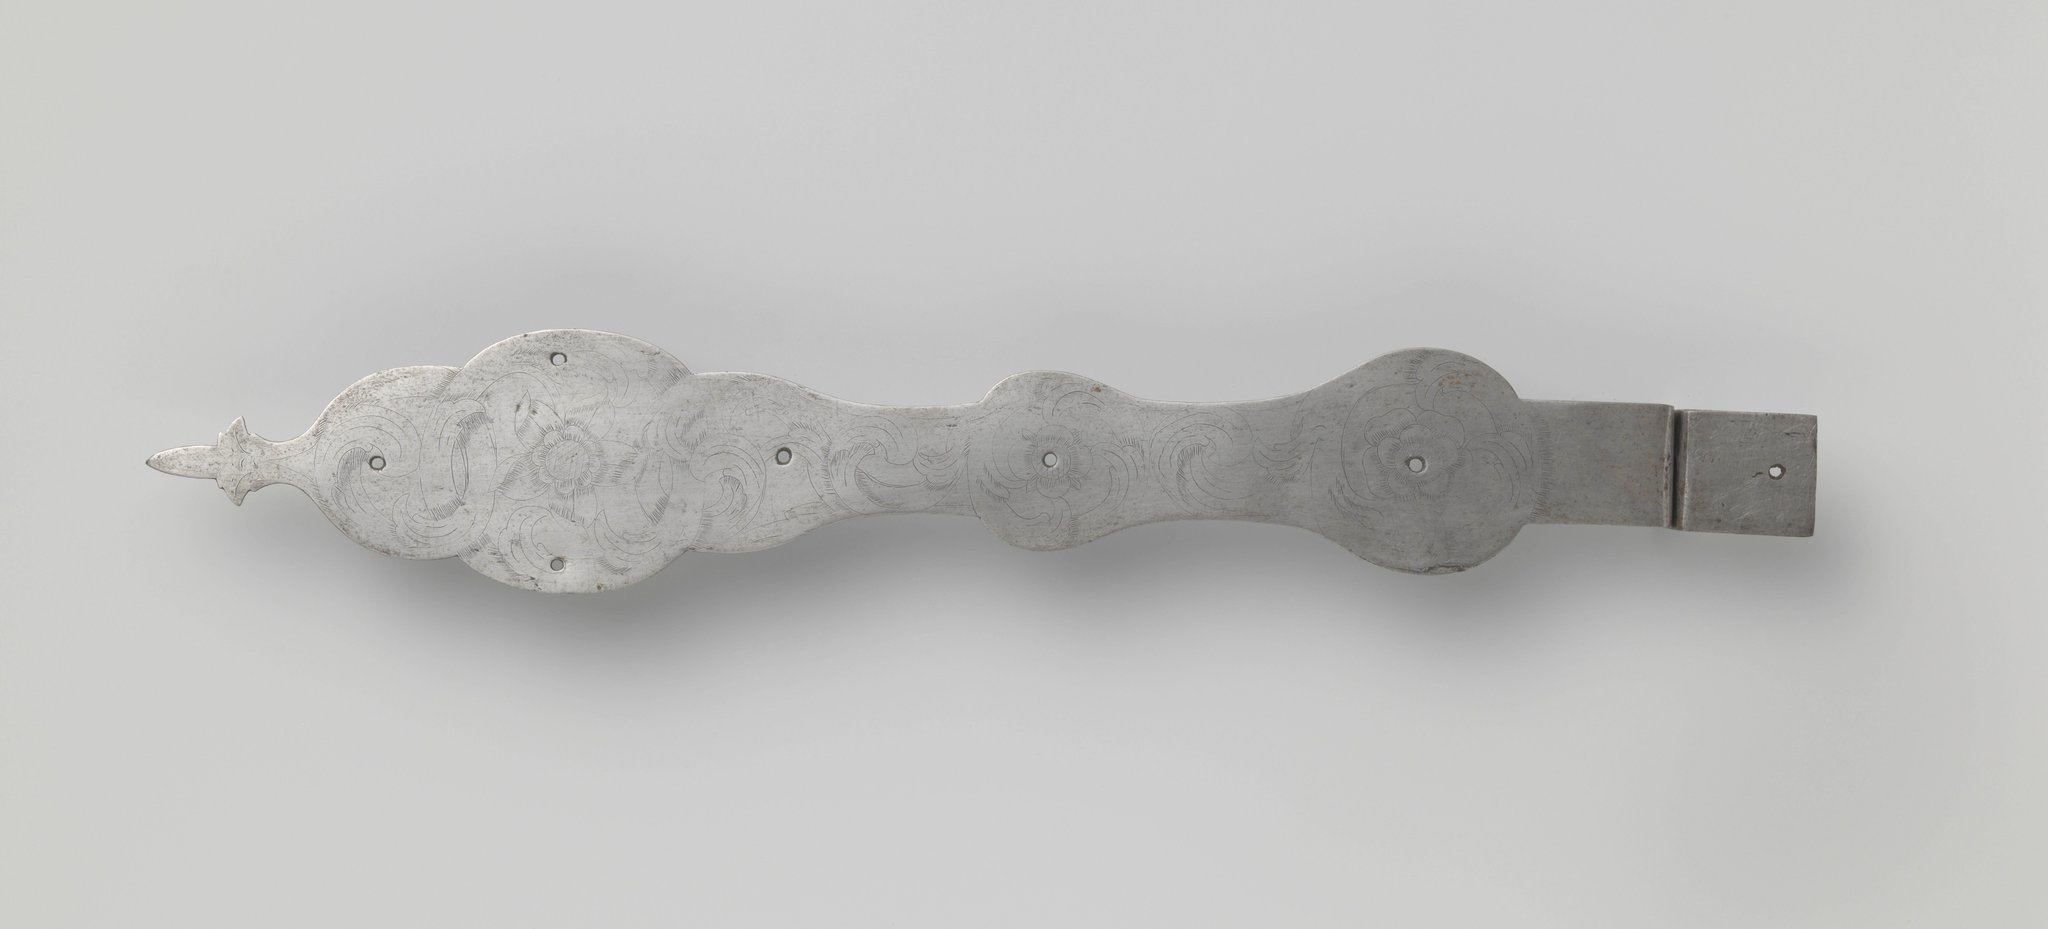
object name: bochthengsel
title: Gegraveerde bochthengsel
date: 1000-2000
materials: metal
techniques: engraving